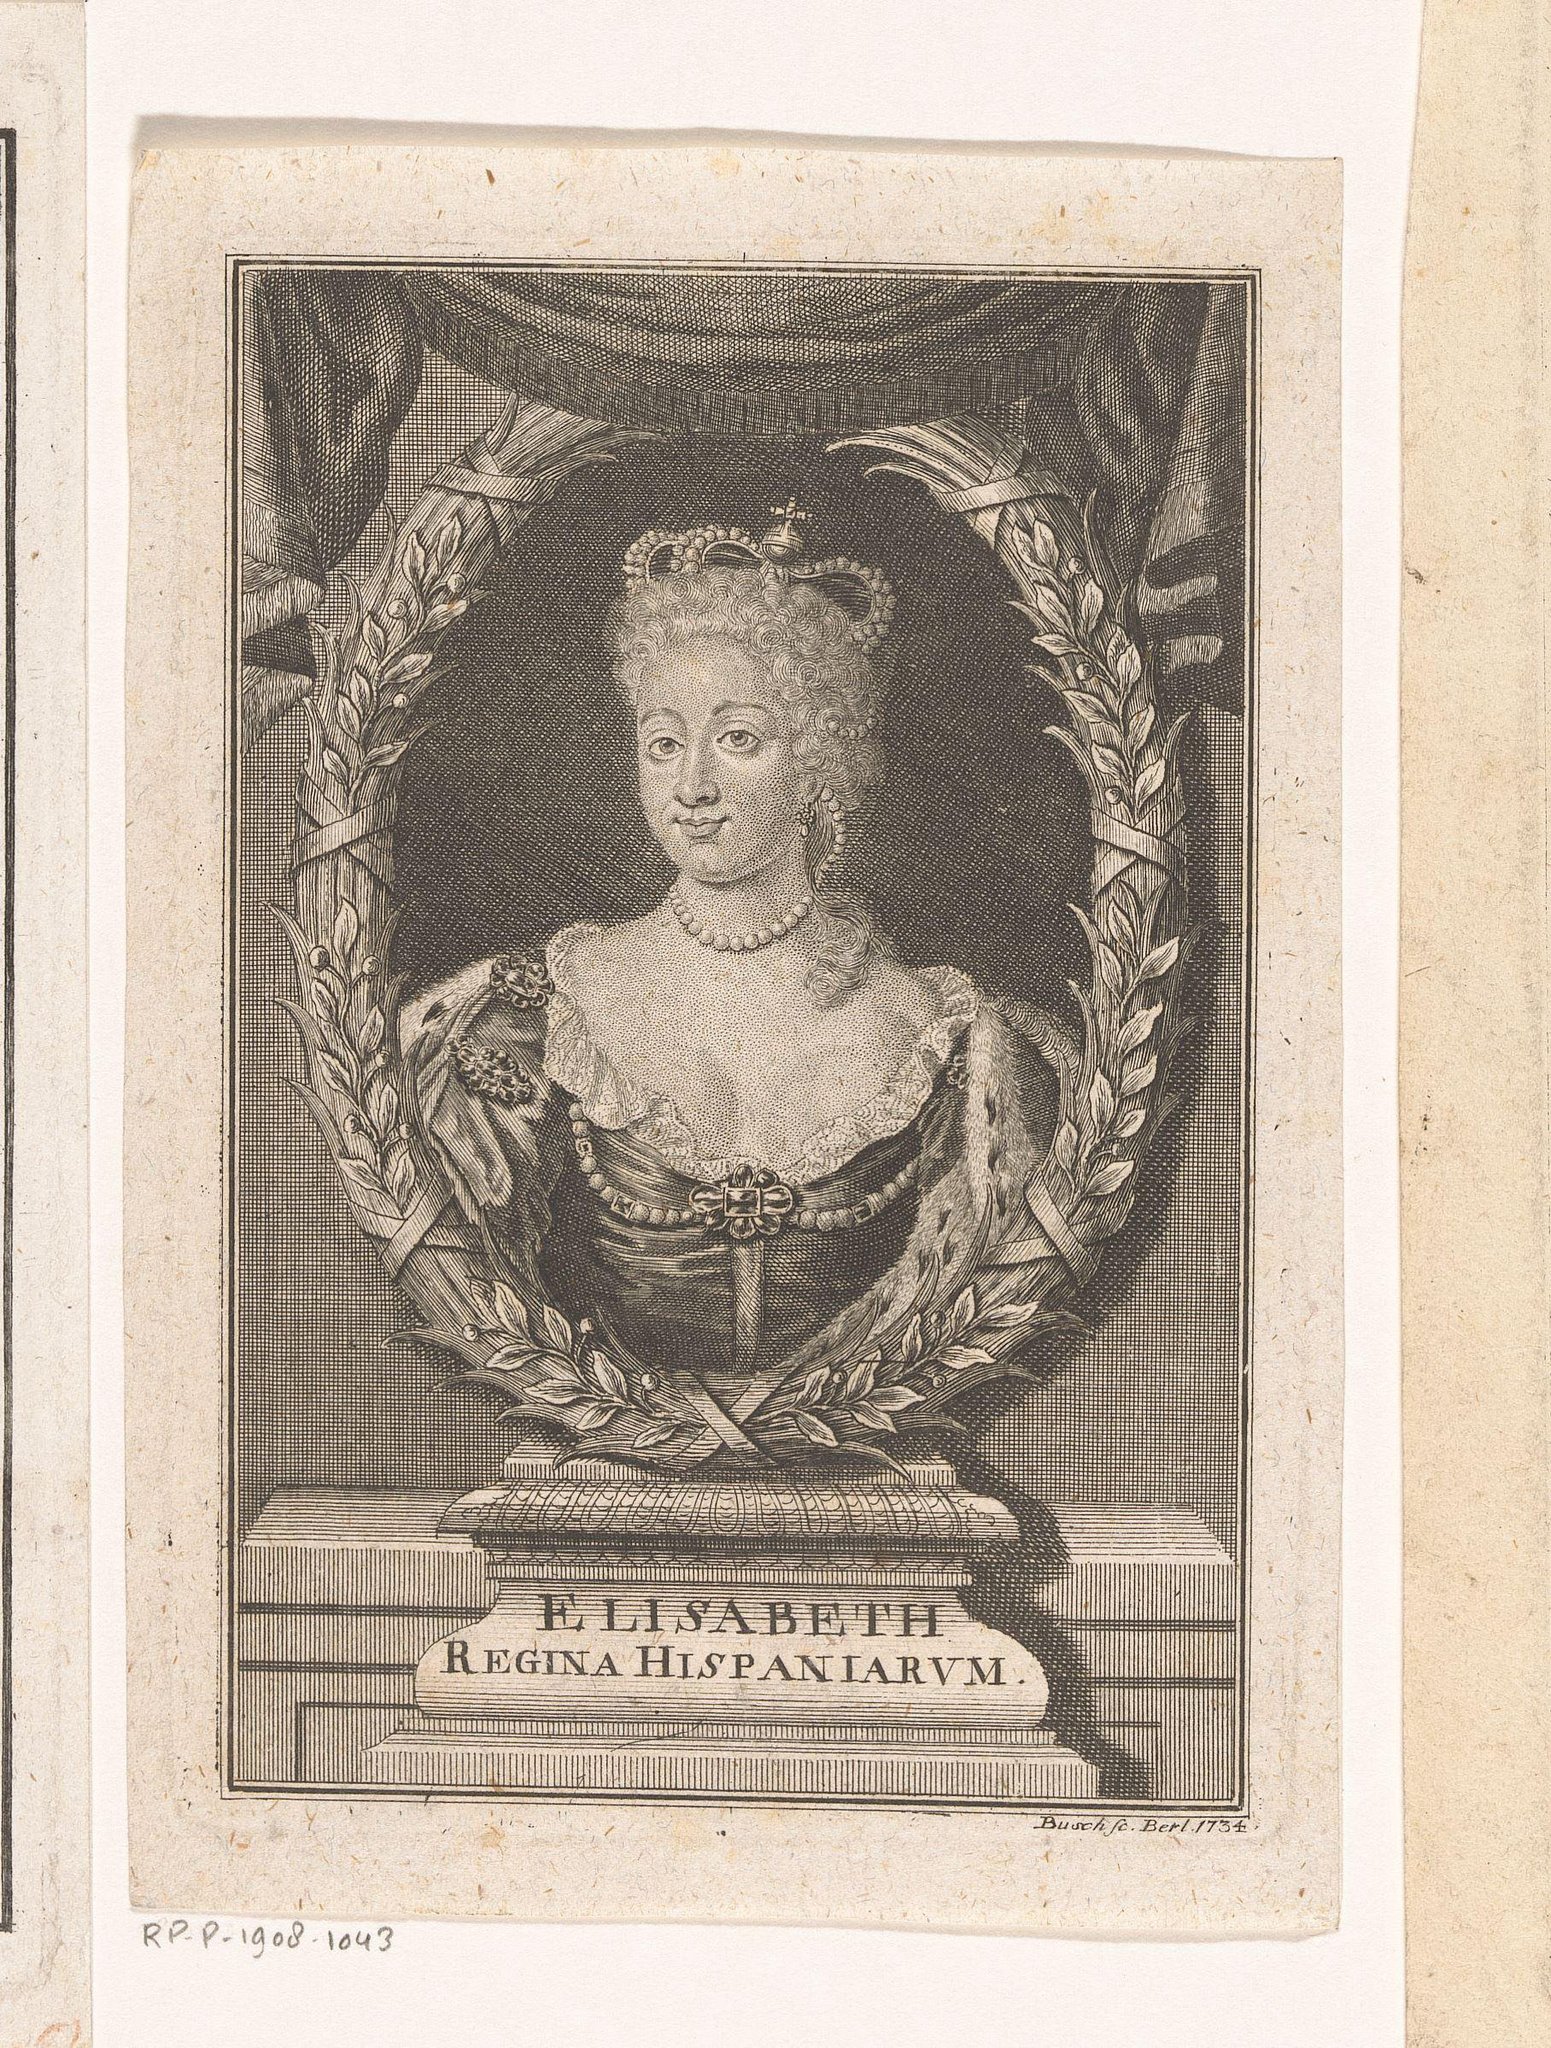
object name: print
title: Portret van Louise Elisabeth d'Orléans, koningin van Spanje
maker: georg paul busch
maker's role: print maker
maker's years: -1756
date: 1734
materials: paper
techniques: engraving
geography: berlin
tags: paris, historical persons - bb - woman, crown (symbol of sovereignty) - bb - female ruler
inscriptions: collector's mark: Lugt 2228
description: Prent ook gebruikt in: Eröffnetes Cabinet Grosser Herren Oder Gegenwärtiger Zustand aller Reiche und Staaten der Welt, Nebst andern Merckwürdigkeiten. dl. 14. Leipzig: Johann Heinrich Zedler, 1734.